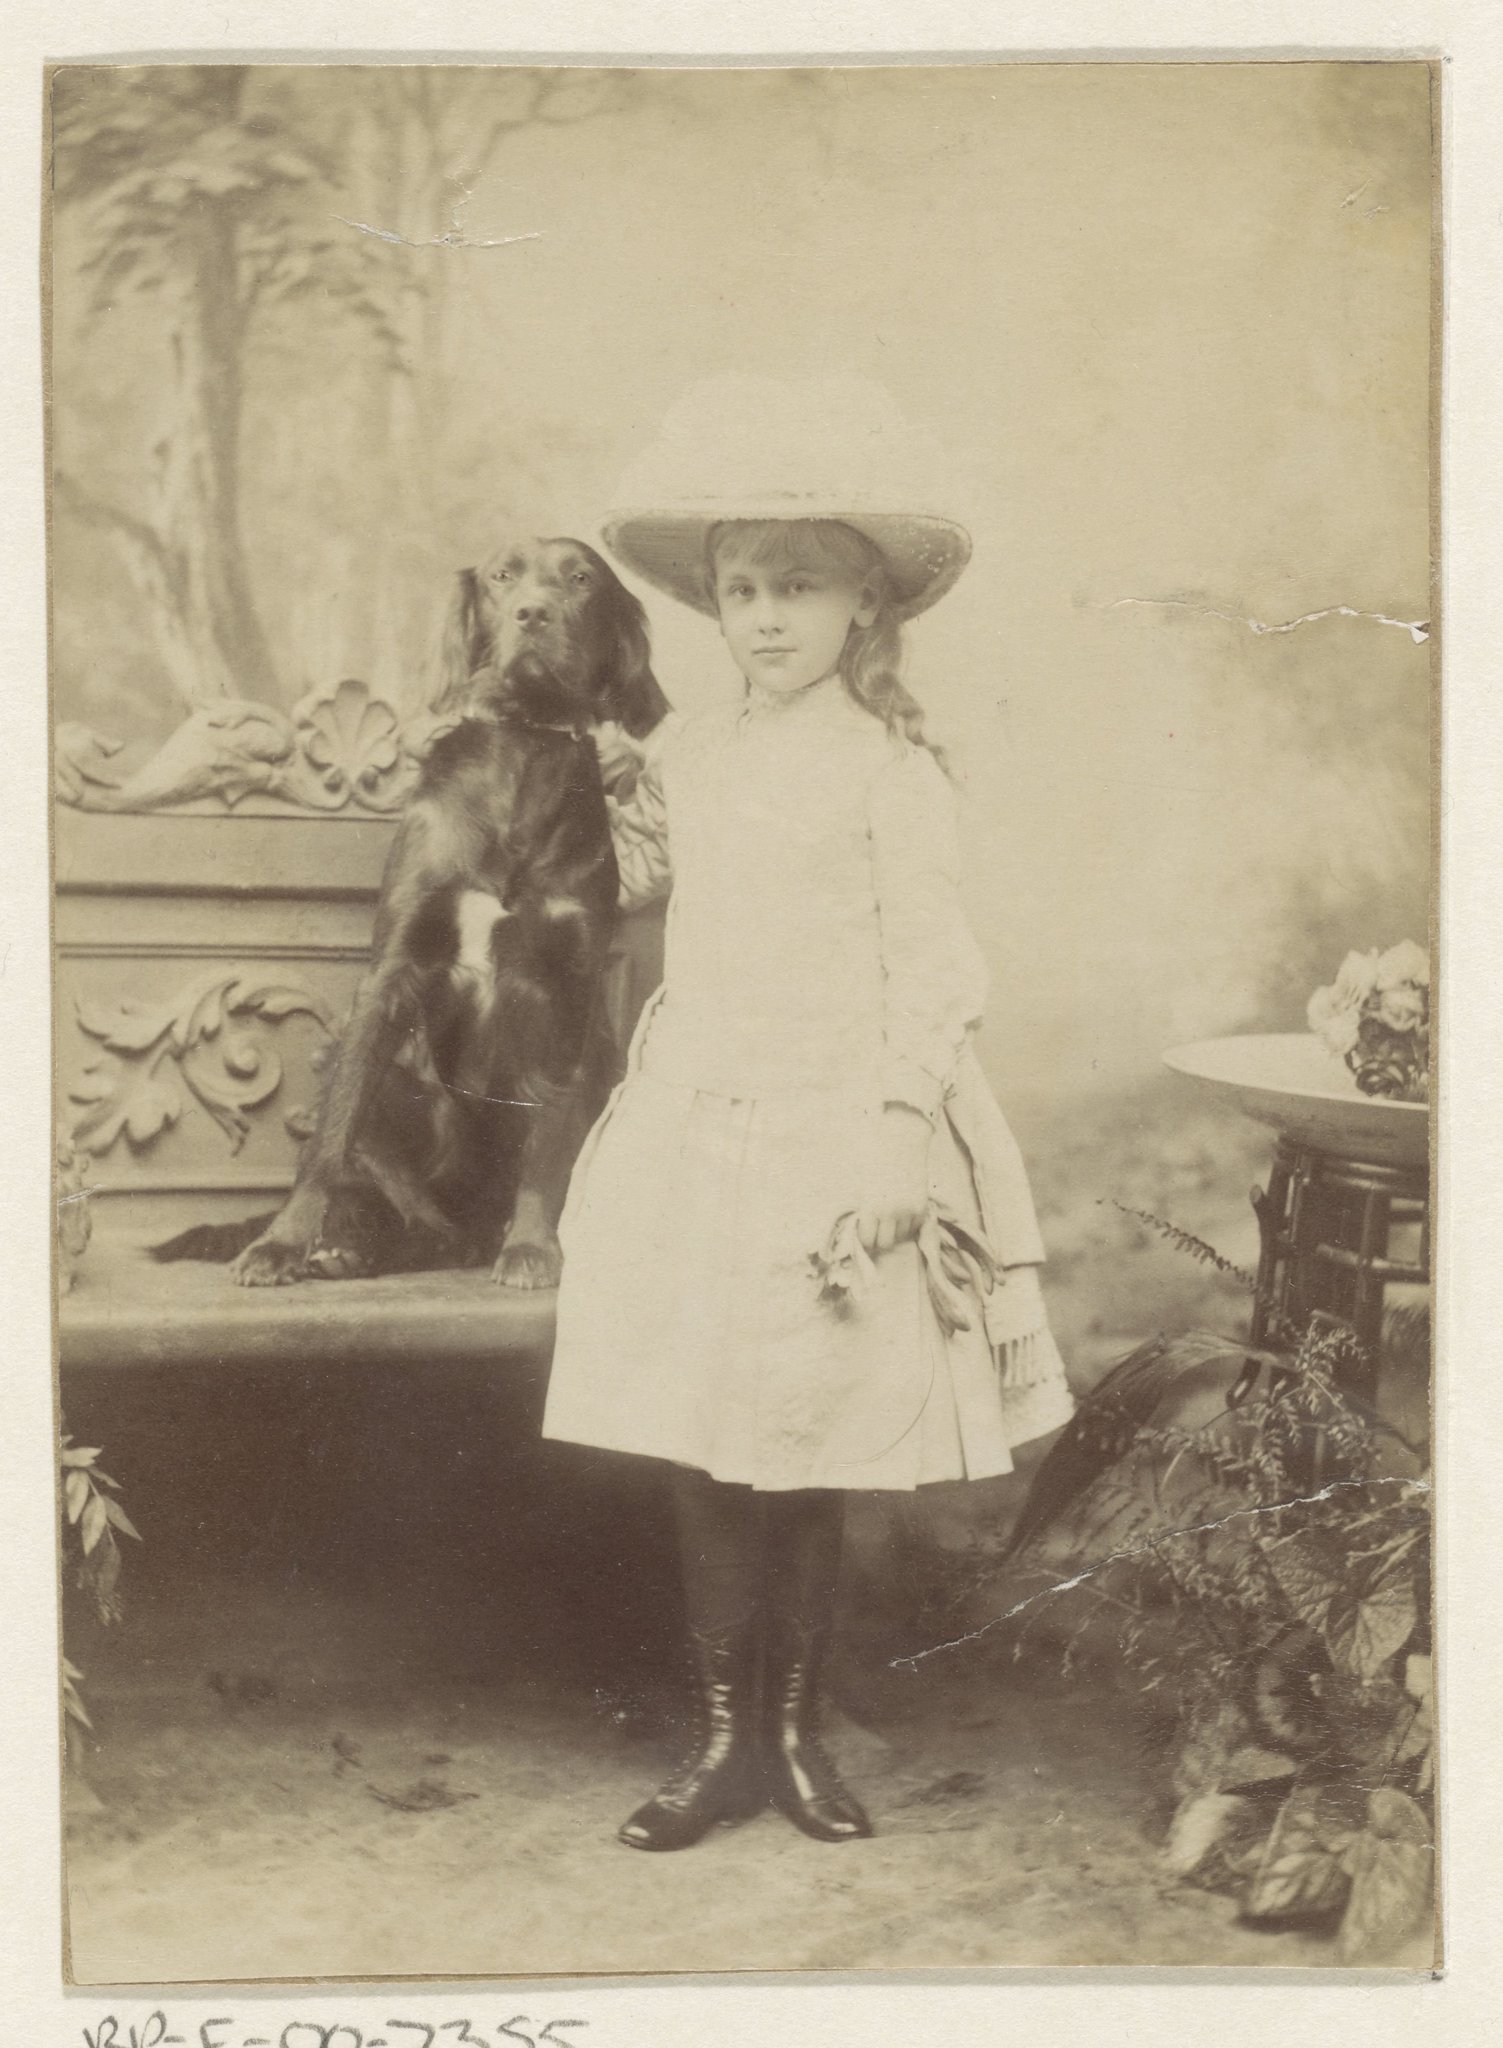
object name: photograph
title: Portret van Wilhelmina, koningin der Nederlanden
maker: Anonymous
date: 1887-1892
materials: paper, photographic support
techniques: albumen print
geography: netherlands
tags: the hague, print maker, wilhelmina of the netherlands, dog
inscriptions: collector's mark: Lugt 2233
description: De hier vermelde titel verwijst naar de hoogst verkregen titel van de geportretteerde, niet per se naar de titel die de geportretteerde op deze voorstelling draagt.